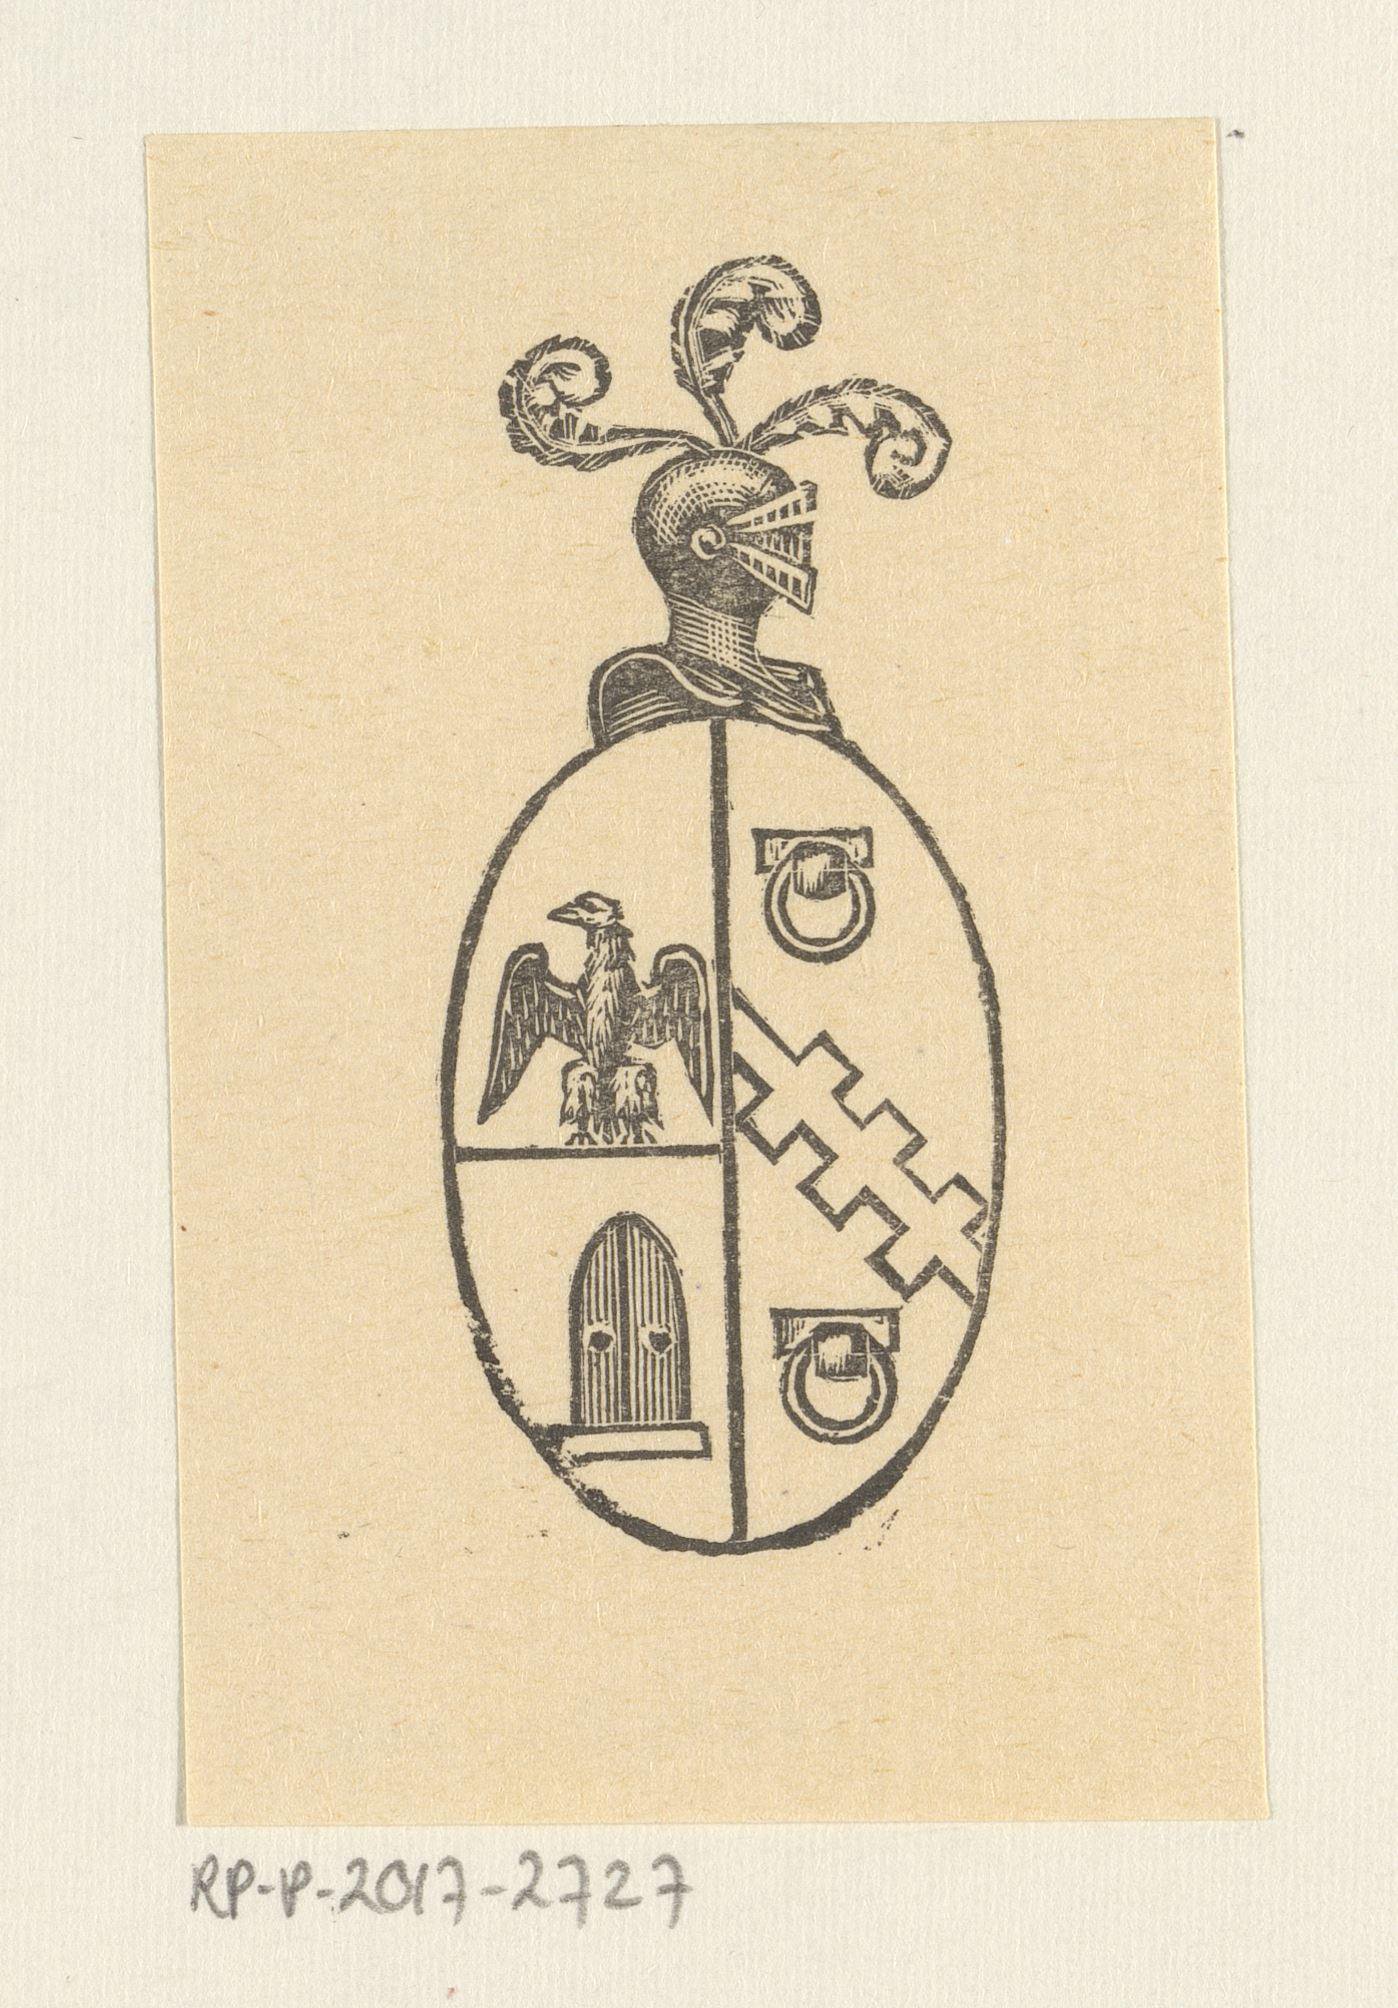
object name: bookplate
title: Ex libris van onbekend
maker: Anonymous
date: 1850-1950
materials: paper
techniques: woodcut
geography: italy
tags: predatory birds: eagle, ship bound for the harbour, armorial bearing, heraldry